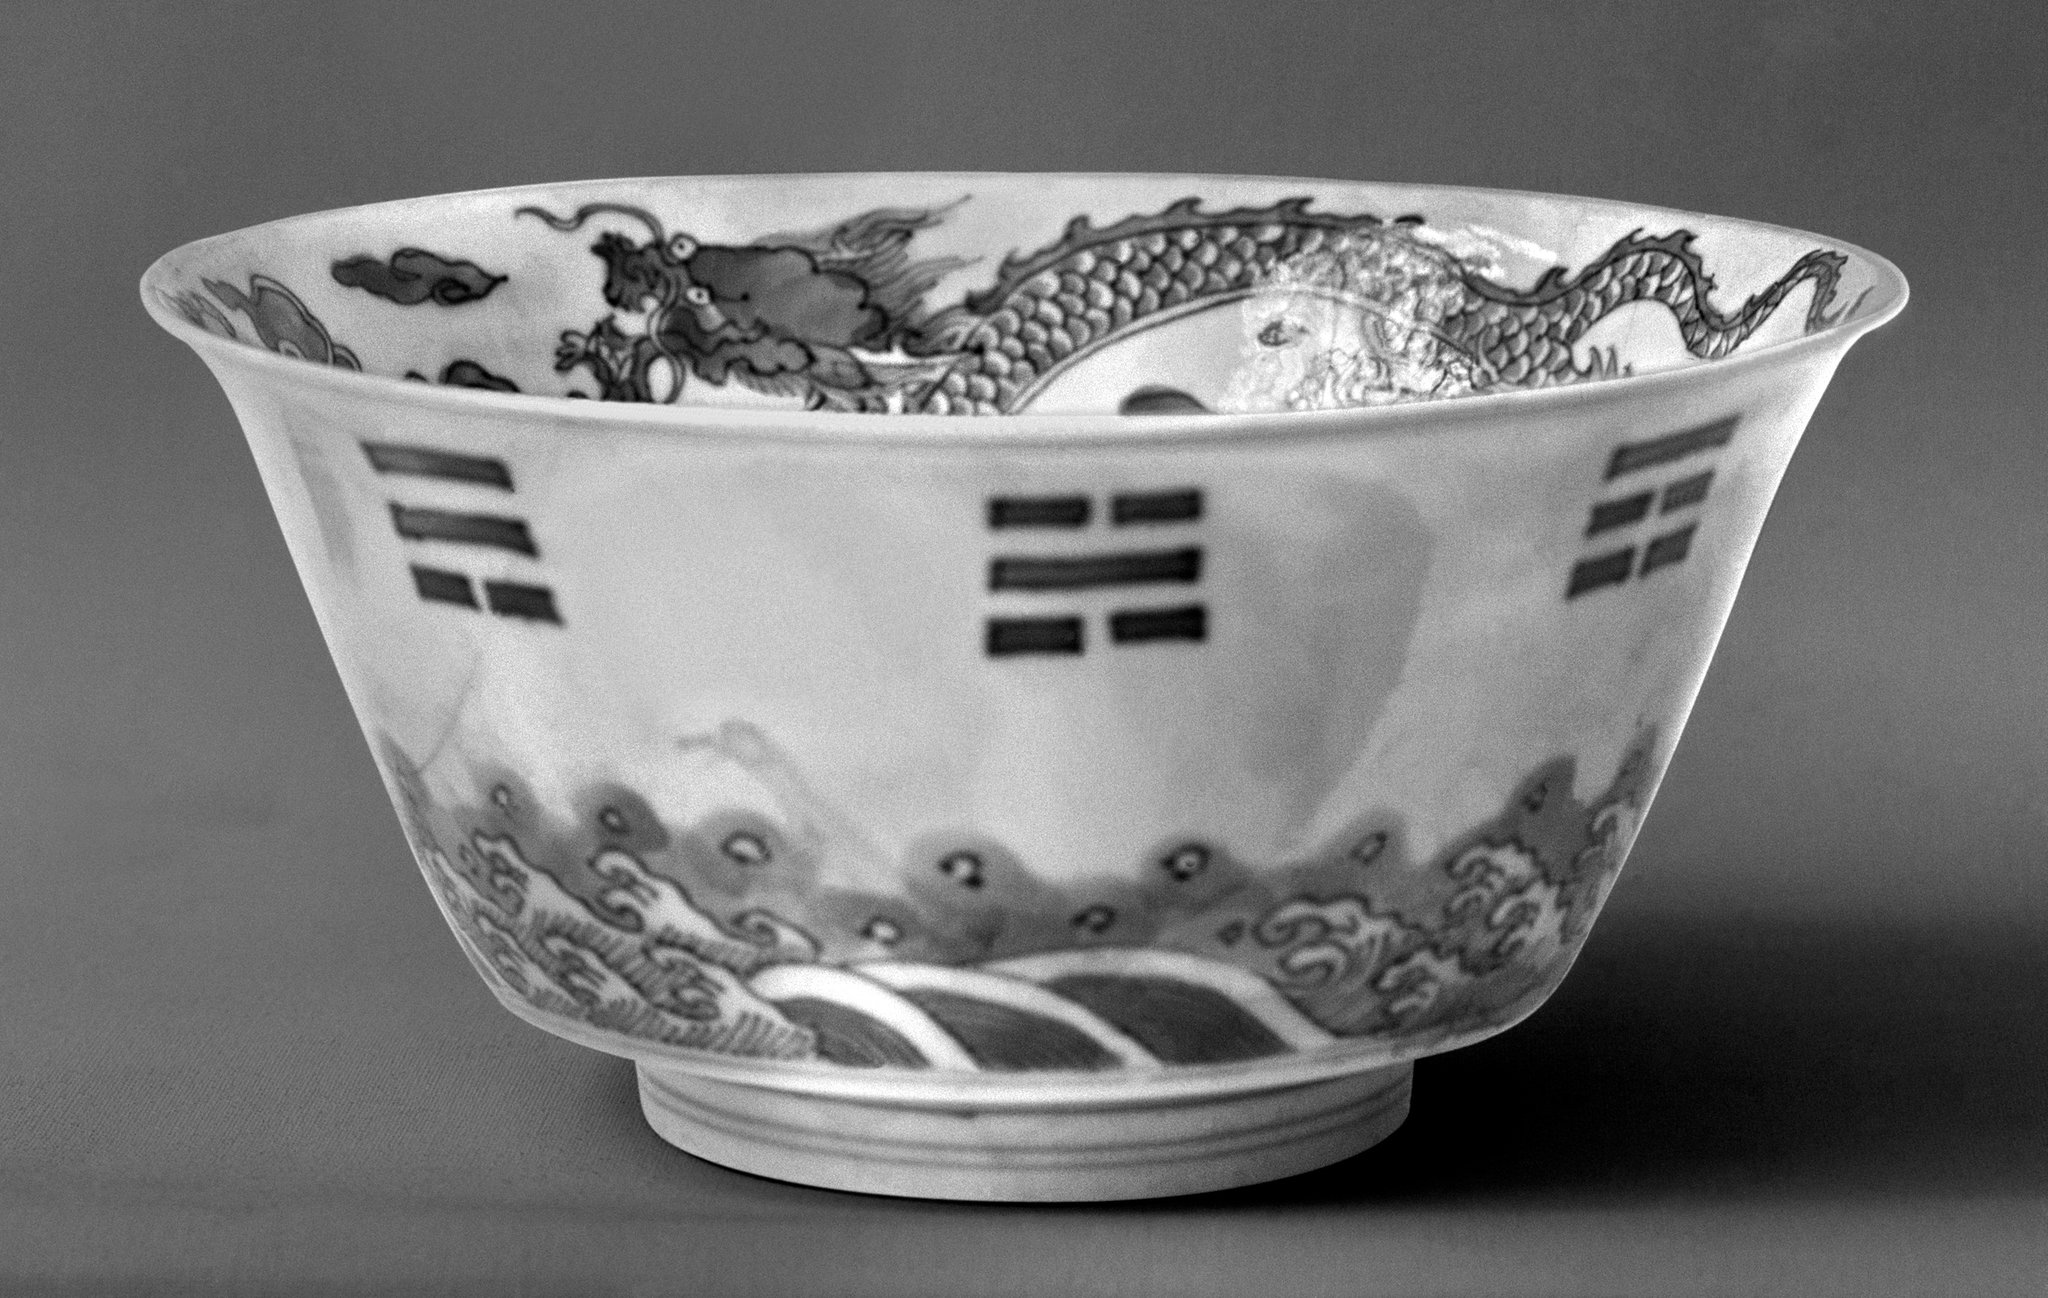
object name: bowl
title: Bowl with dragons and eight trigrams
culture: chinese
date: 1701-1733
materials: cobalt, porcelain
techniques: painting, underglaze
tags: dragons